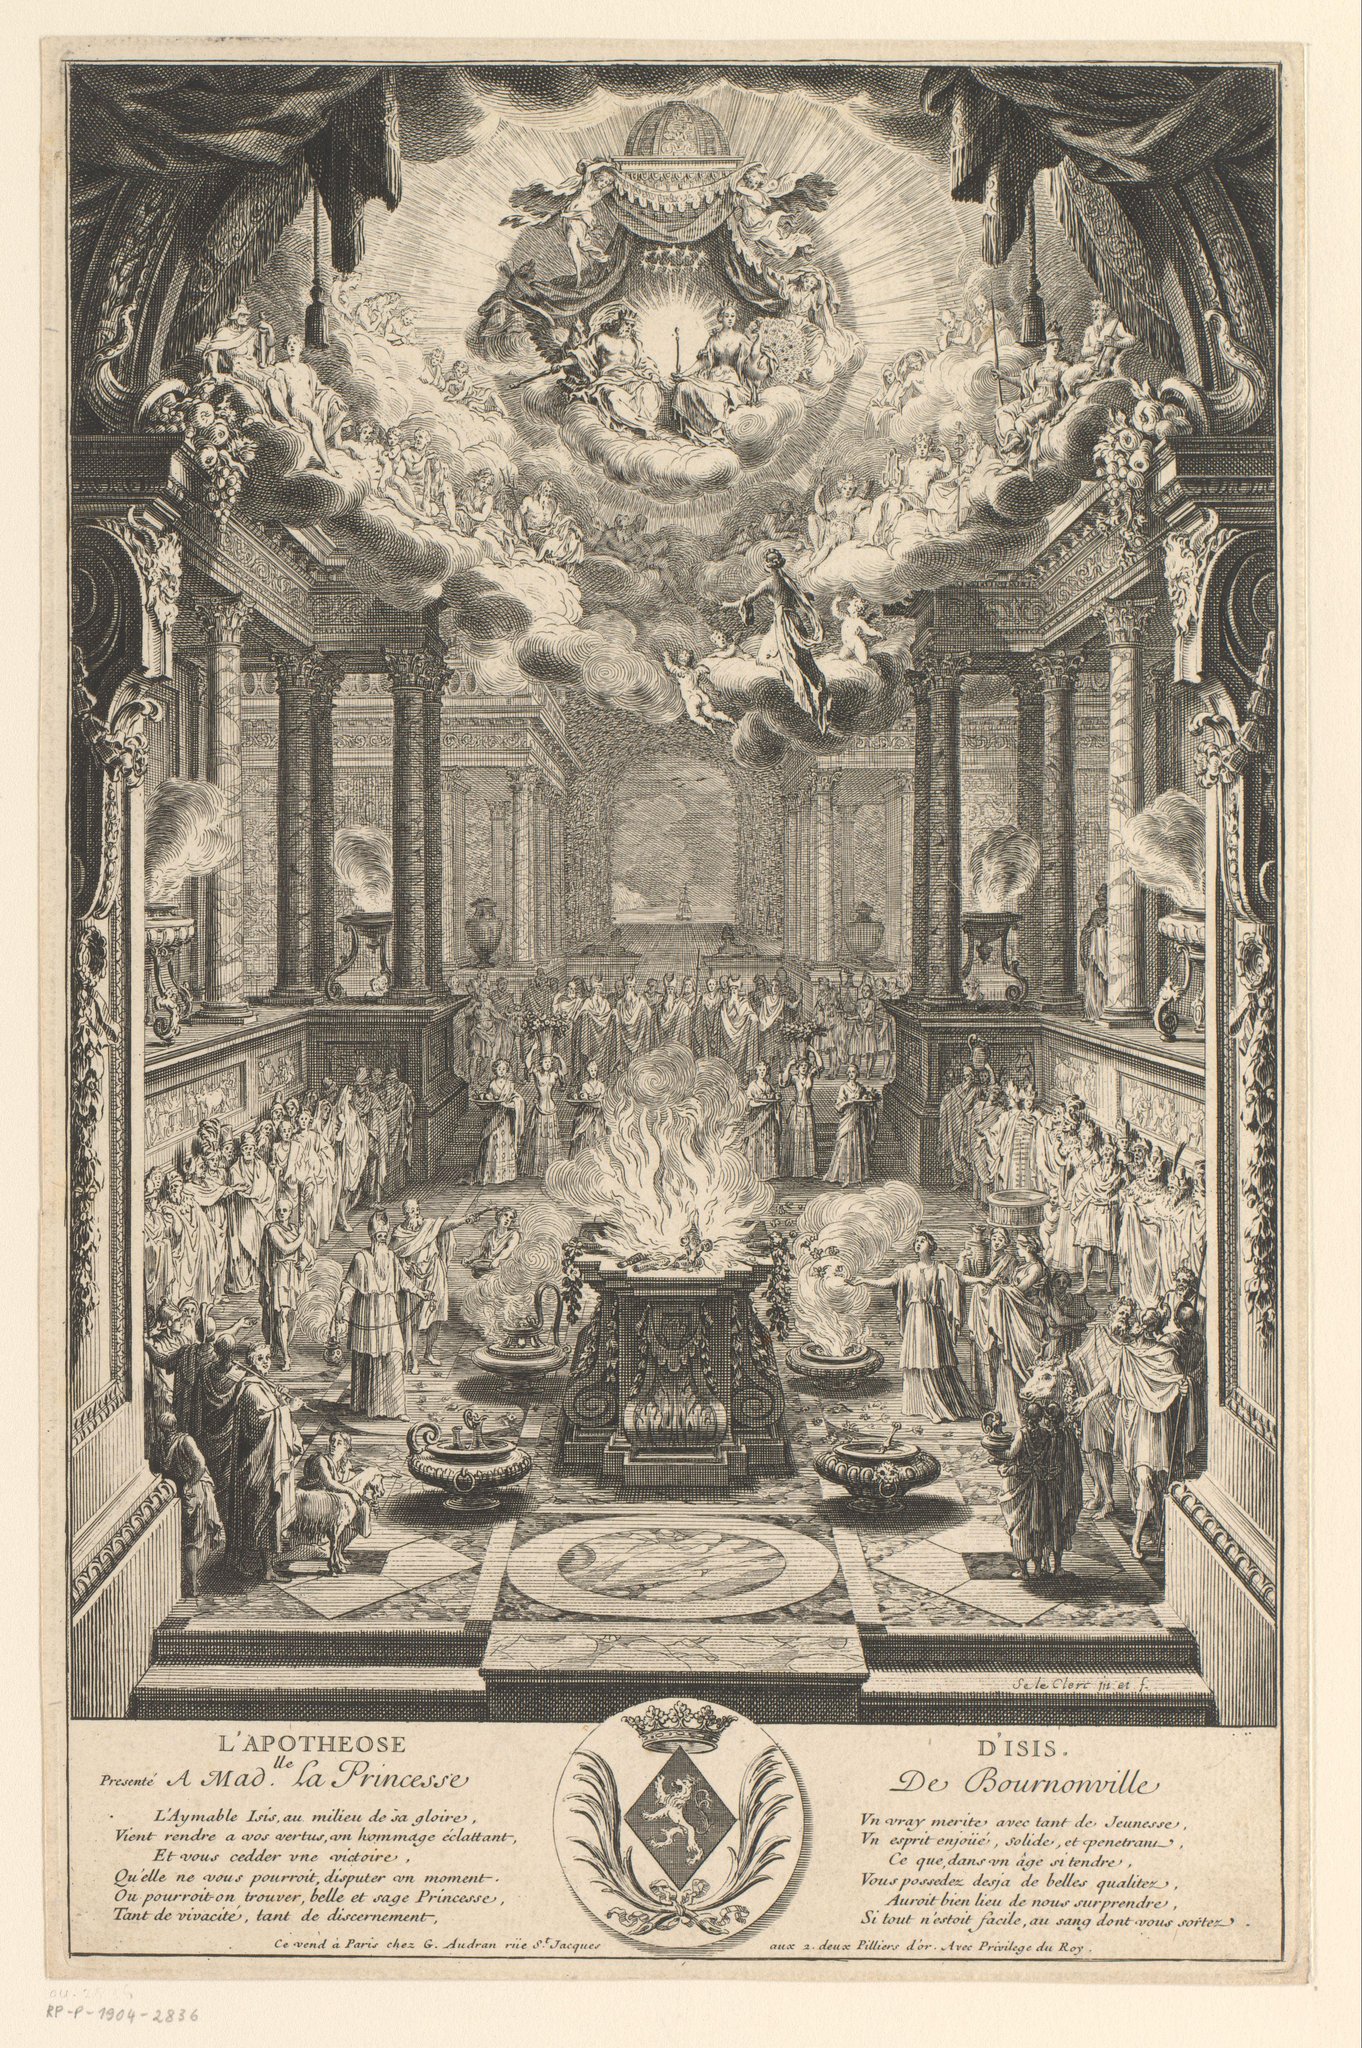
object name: print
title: Apotheose van Isis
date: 1693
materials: paper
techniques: engraving, etching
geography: france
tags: suffering, misfortune of isis - apotheosis, deification of non-christian god or goddess, armorial bearing, heraldry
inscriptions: collector's mark: Lugt 2228